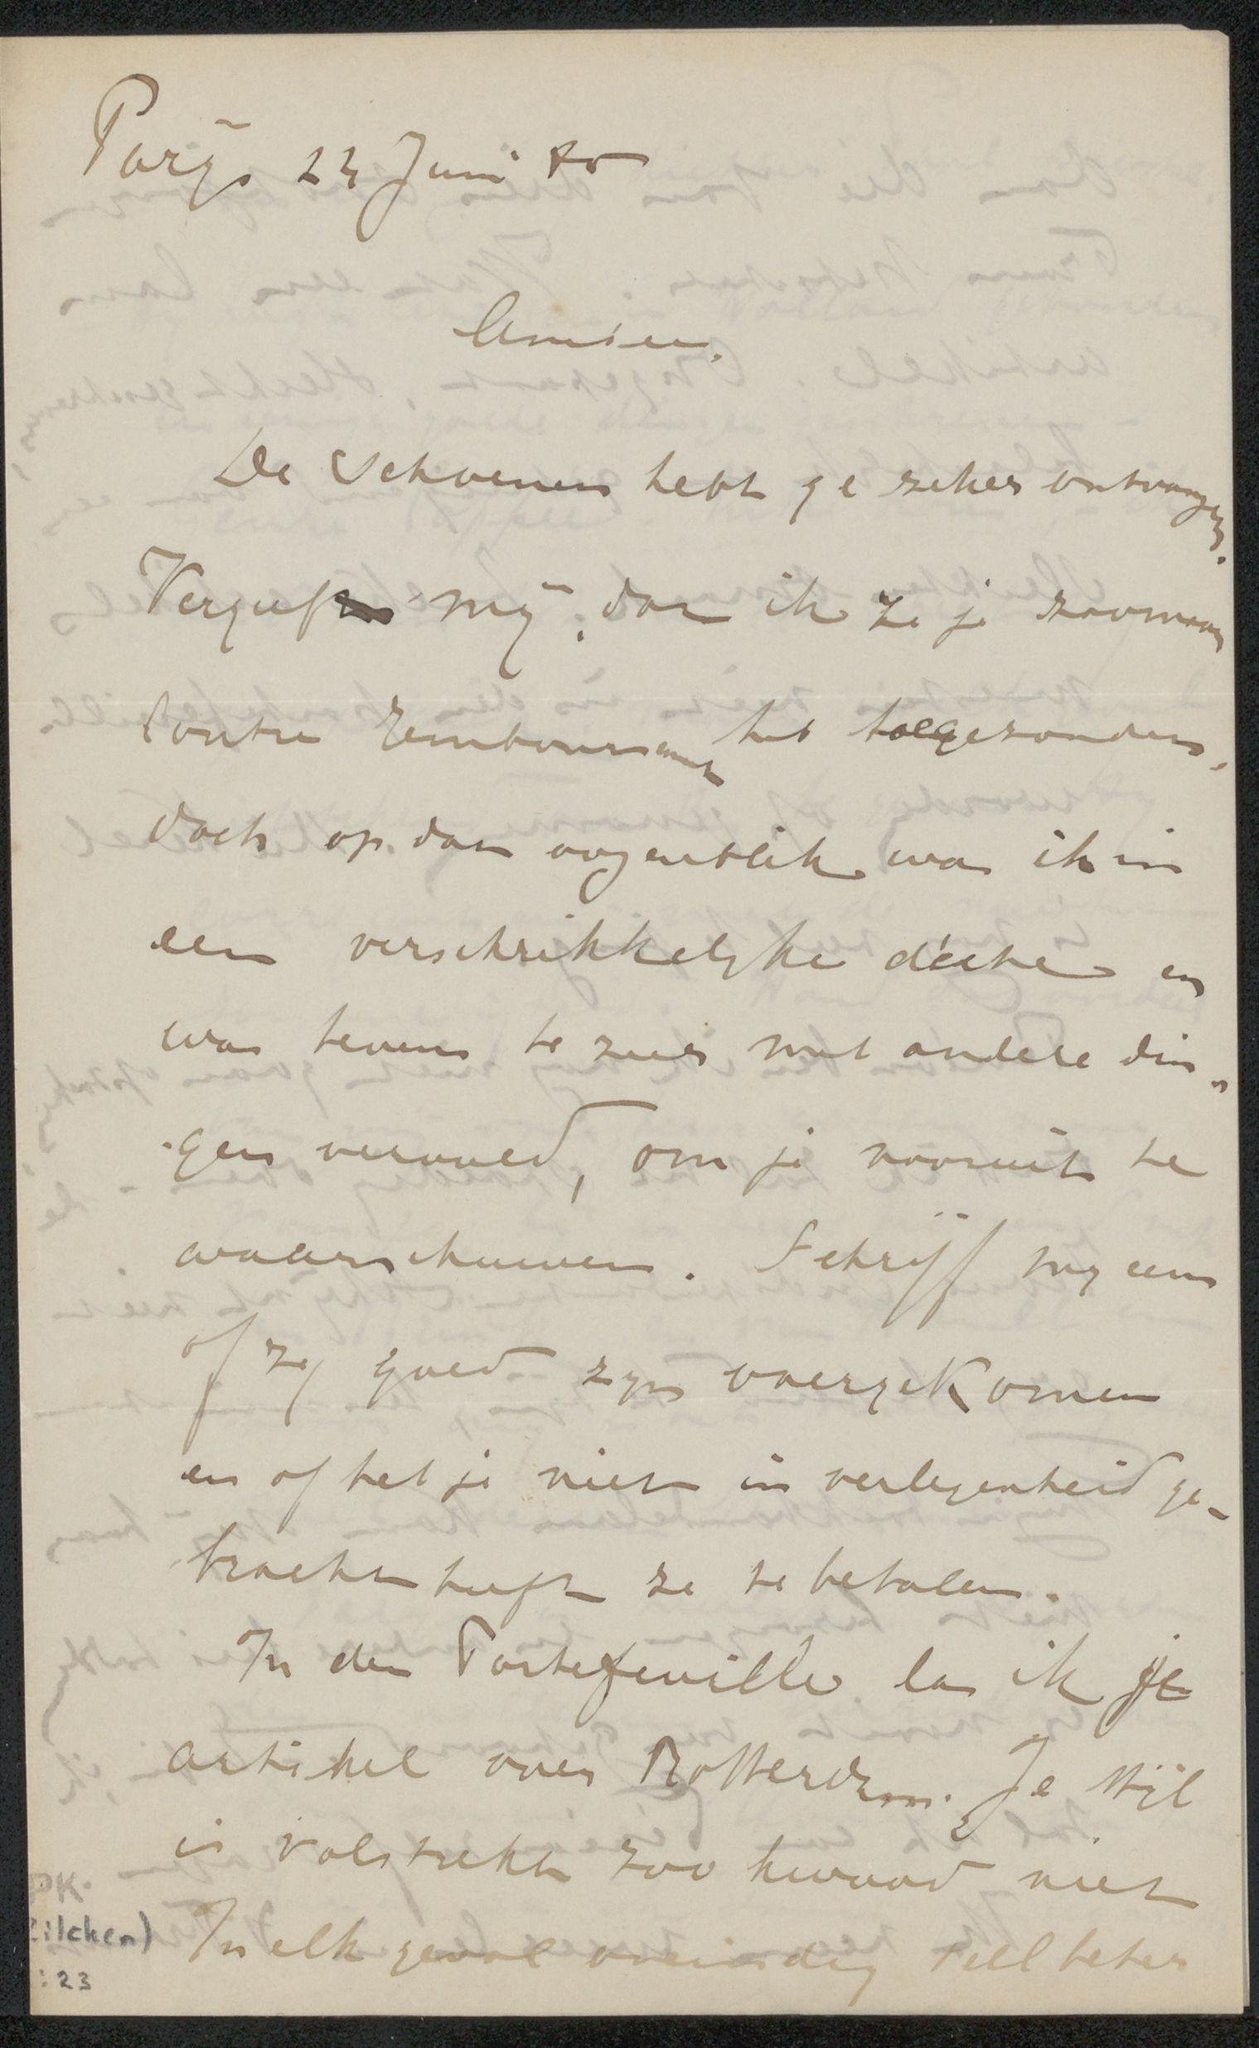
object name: letter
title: Brief aan Philip Zilcken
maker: adriaan pit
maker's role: print maker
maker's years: 1860-1944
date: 1885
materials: ink, paper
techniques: pen, writing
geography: paris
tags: marinus van der maarel, leiden, jan ten brink (1834-1901), félix fénéon, haarlem, frans netscher, painter, draughtsman, philip zilcken, applied arts, arts and crafts; industrial design, rotterdam, paris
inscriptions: collector's mark: ‘RPK’, watermark